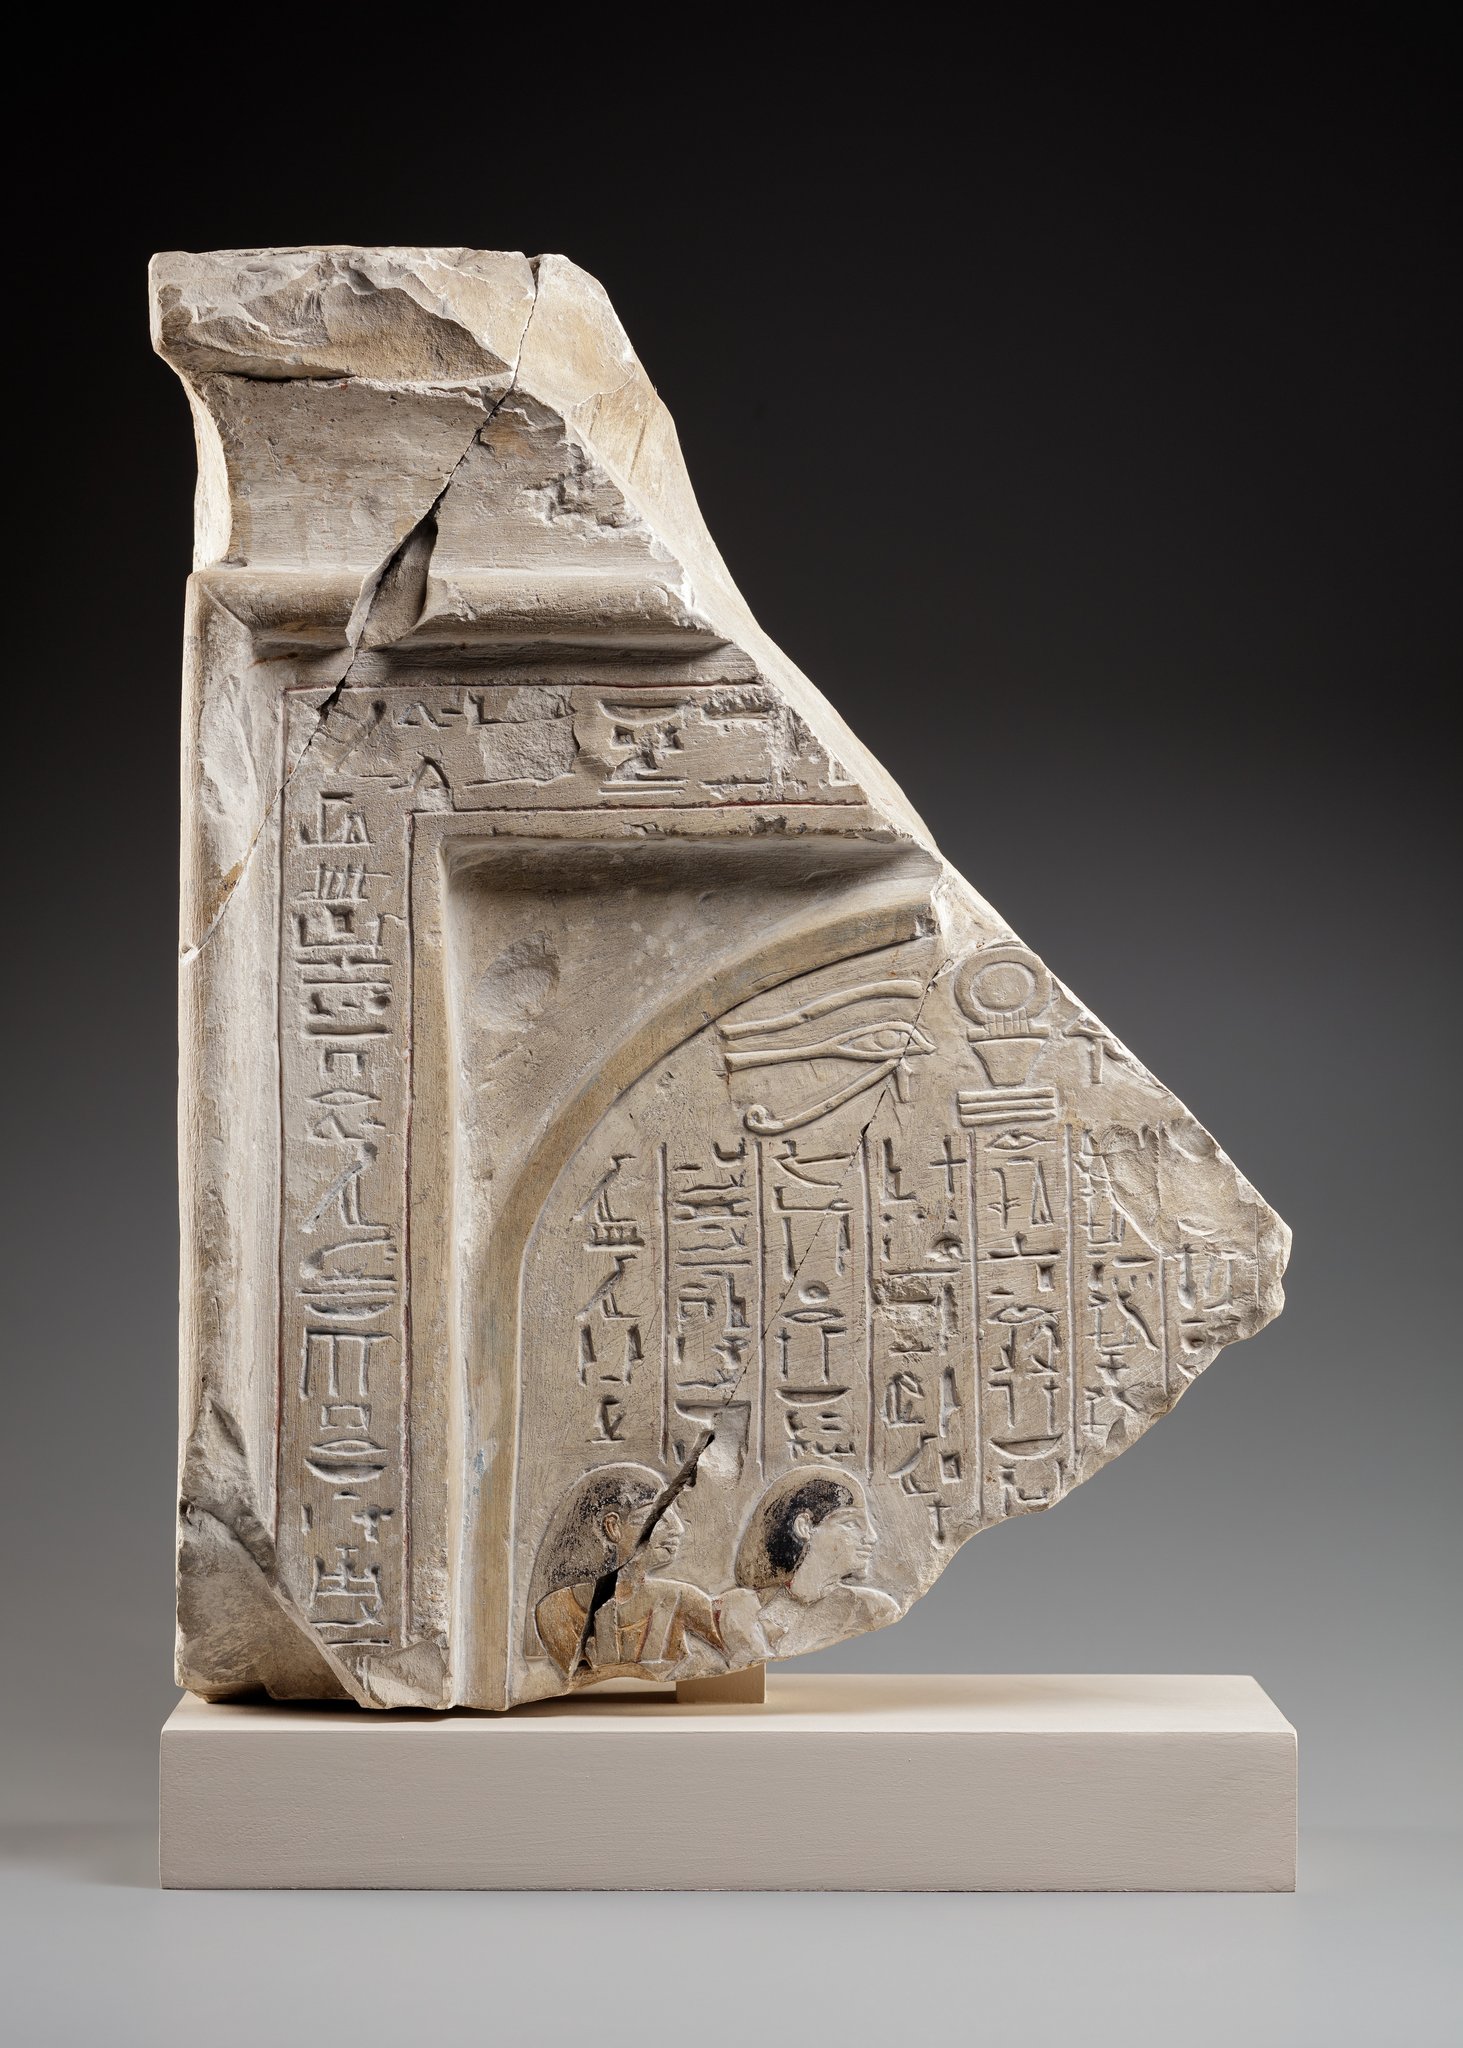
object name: stela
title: Stela of Ipunefer and Aashyt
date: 1550-1425 BCE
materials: limestone, paint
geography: egypt